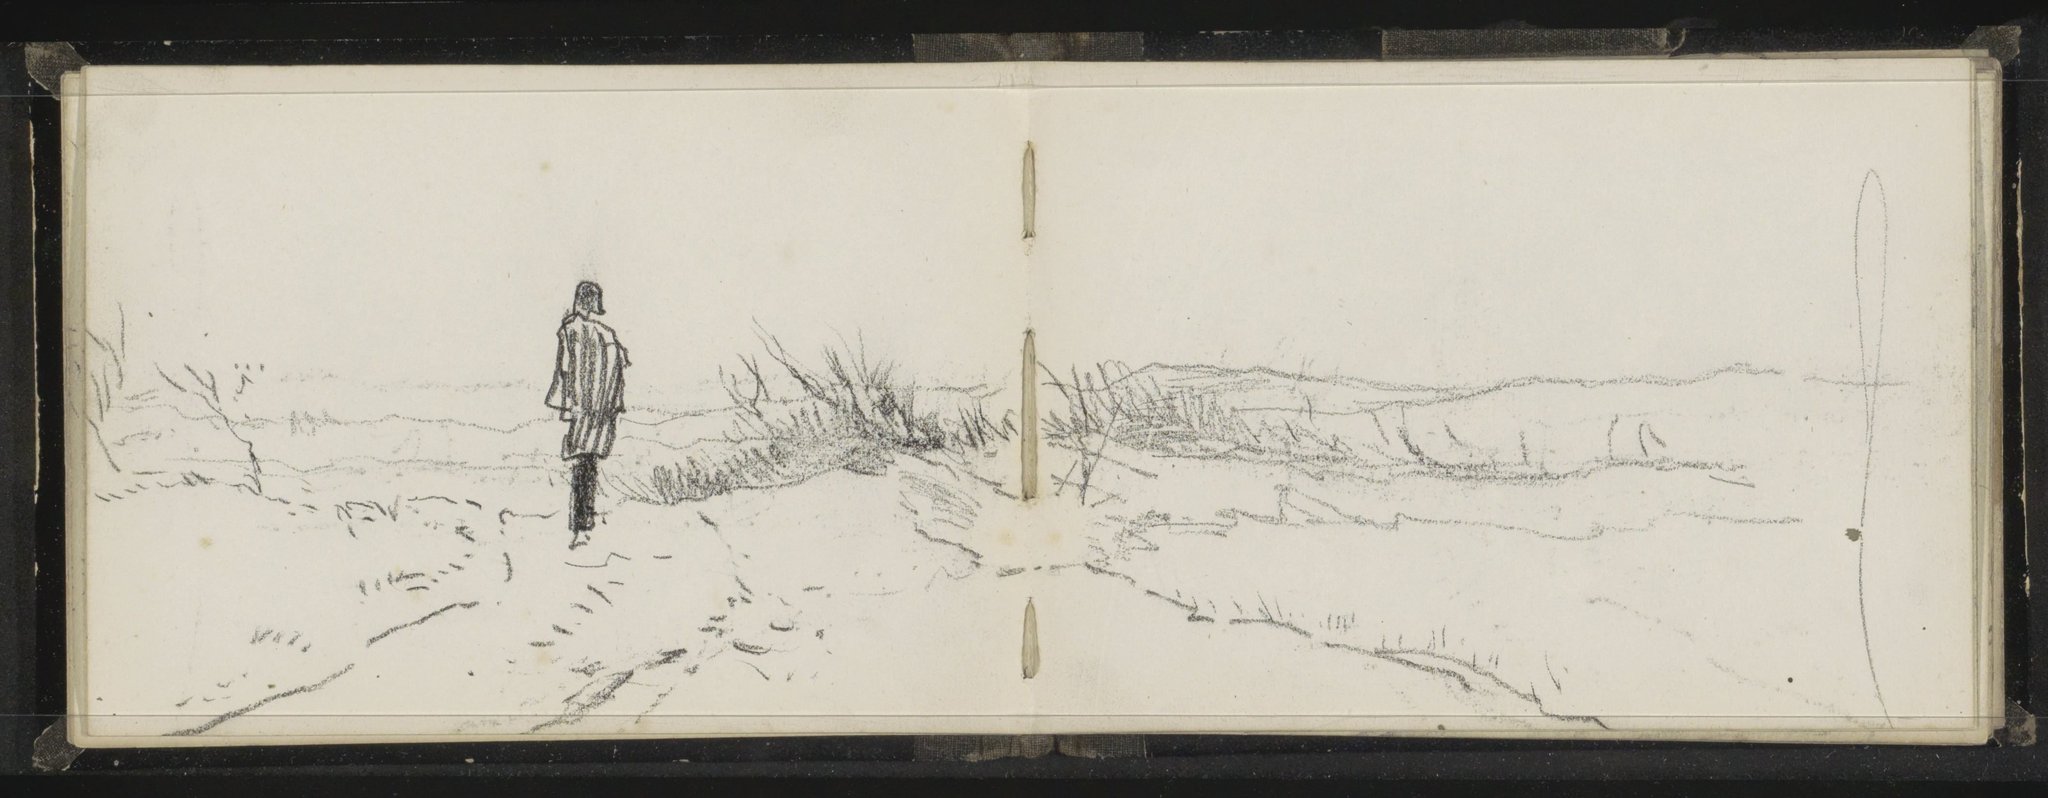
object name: sketchbook leaf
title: Staande figuur in een landschap met struiken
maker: anton mauve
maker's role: draughtsman, painter, print maker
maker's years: 1838-1888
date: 1848-1888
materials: chalk, paper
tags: landscapes (+ landscape with figures, staffage)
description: Blad 11 verso en 12 recto uit een schetsboek met 33 bladen.